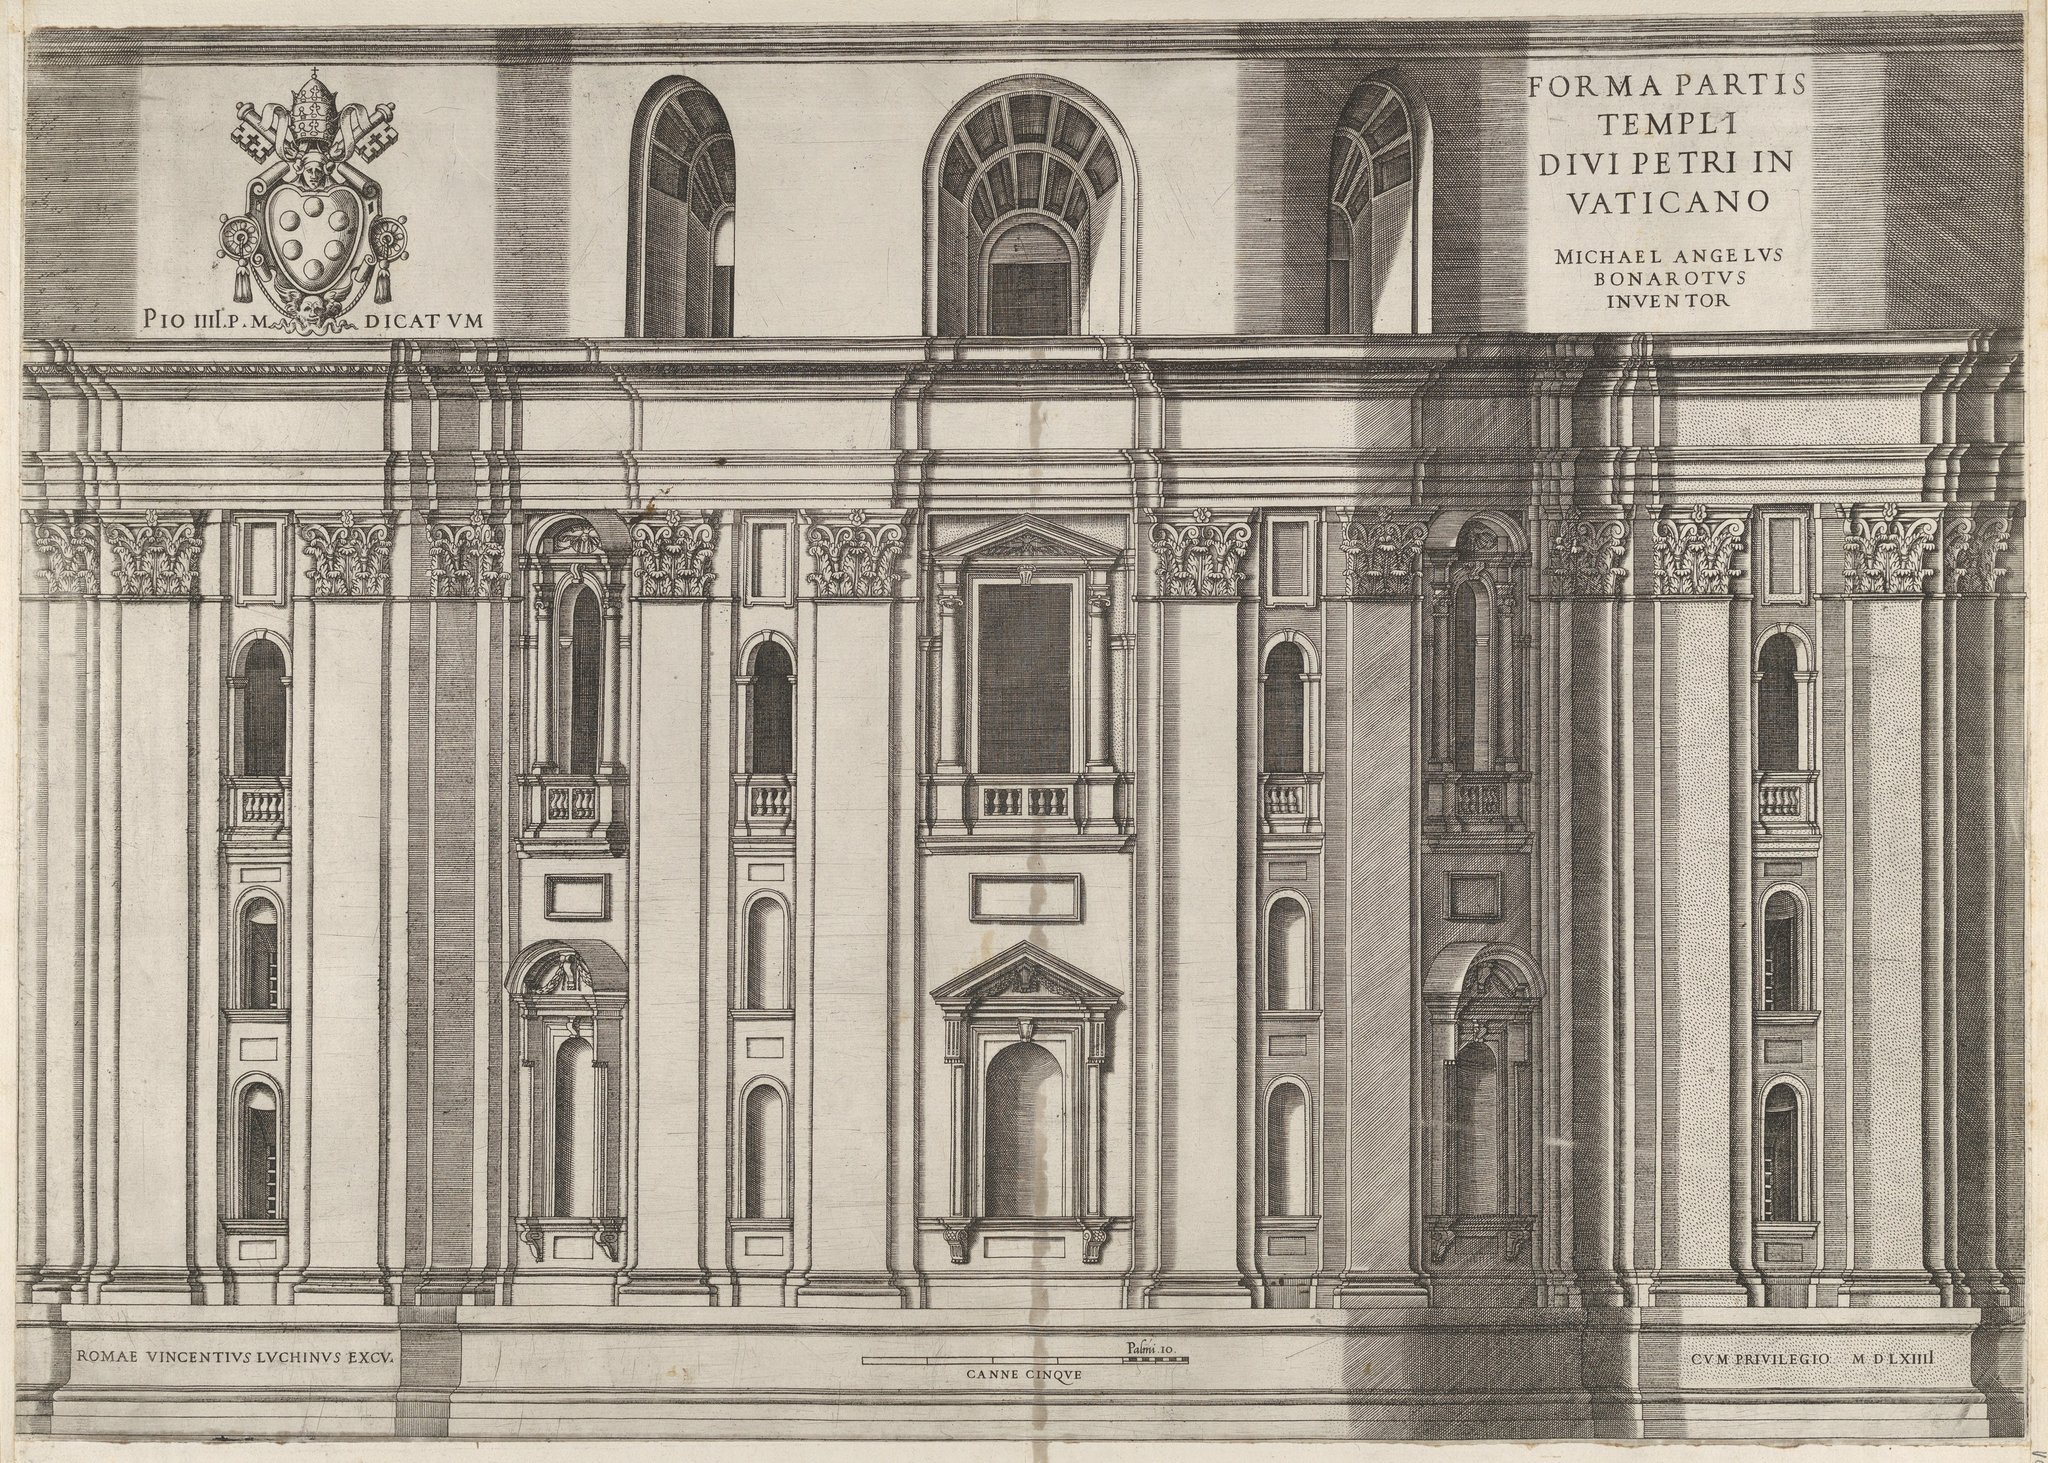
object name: print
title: St. Peter's, from "Speculum Romanae Magnificentiae"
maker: vincenzo luchino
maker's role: artist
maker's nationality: italian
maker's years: 1552-1571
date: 1564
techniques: engraving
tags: architecture,buildings,insignia,rome